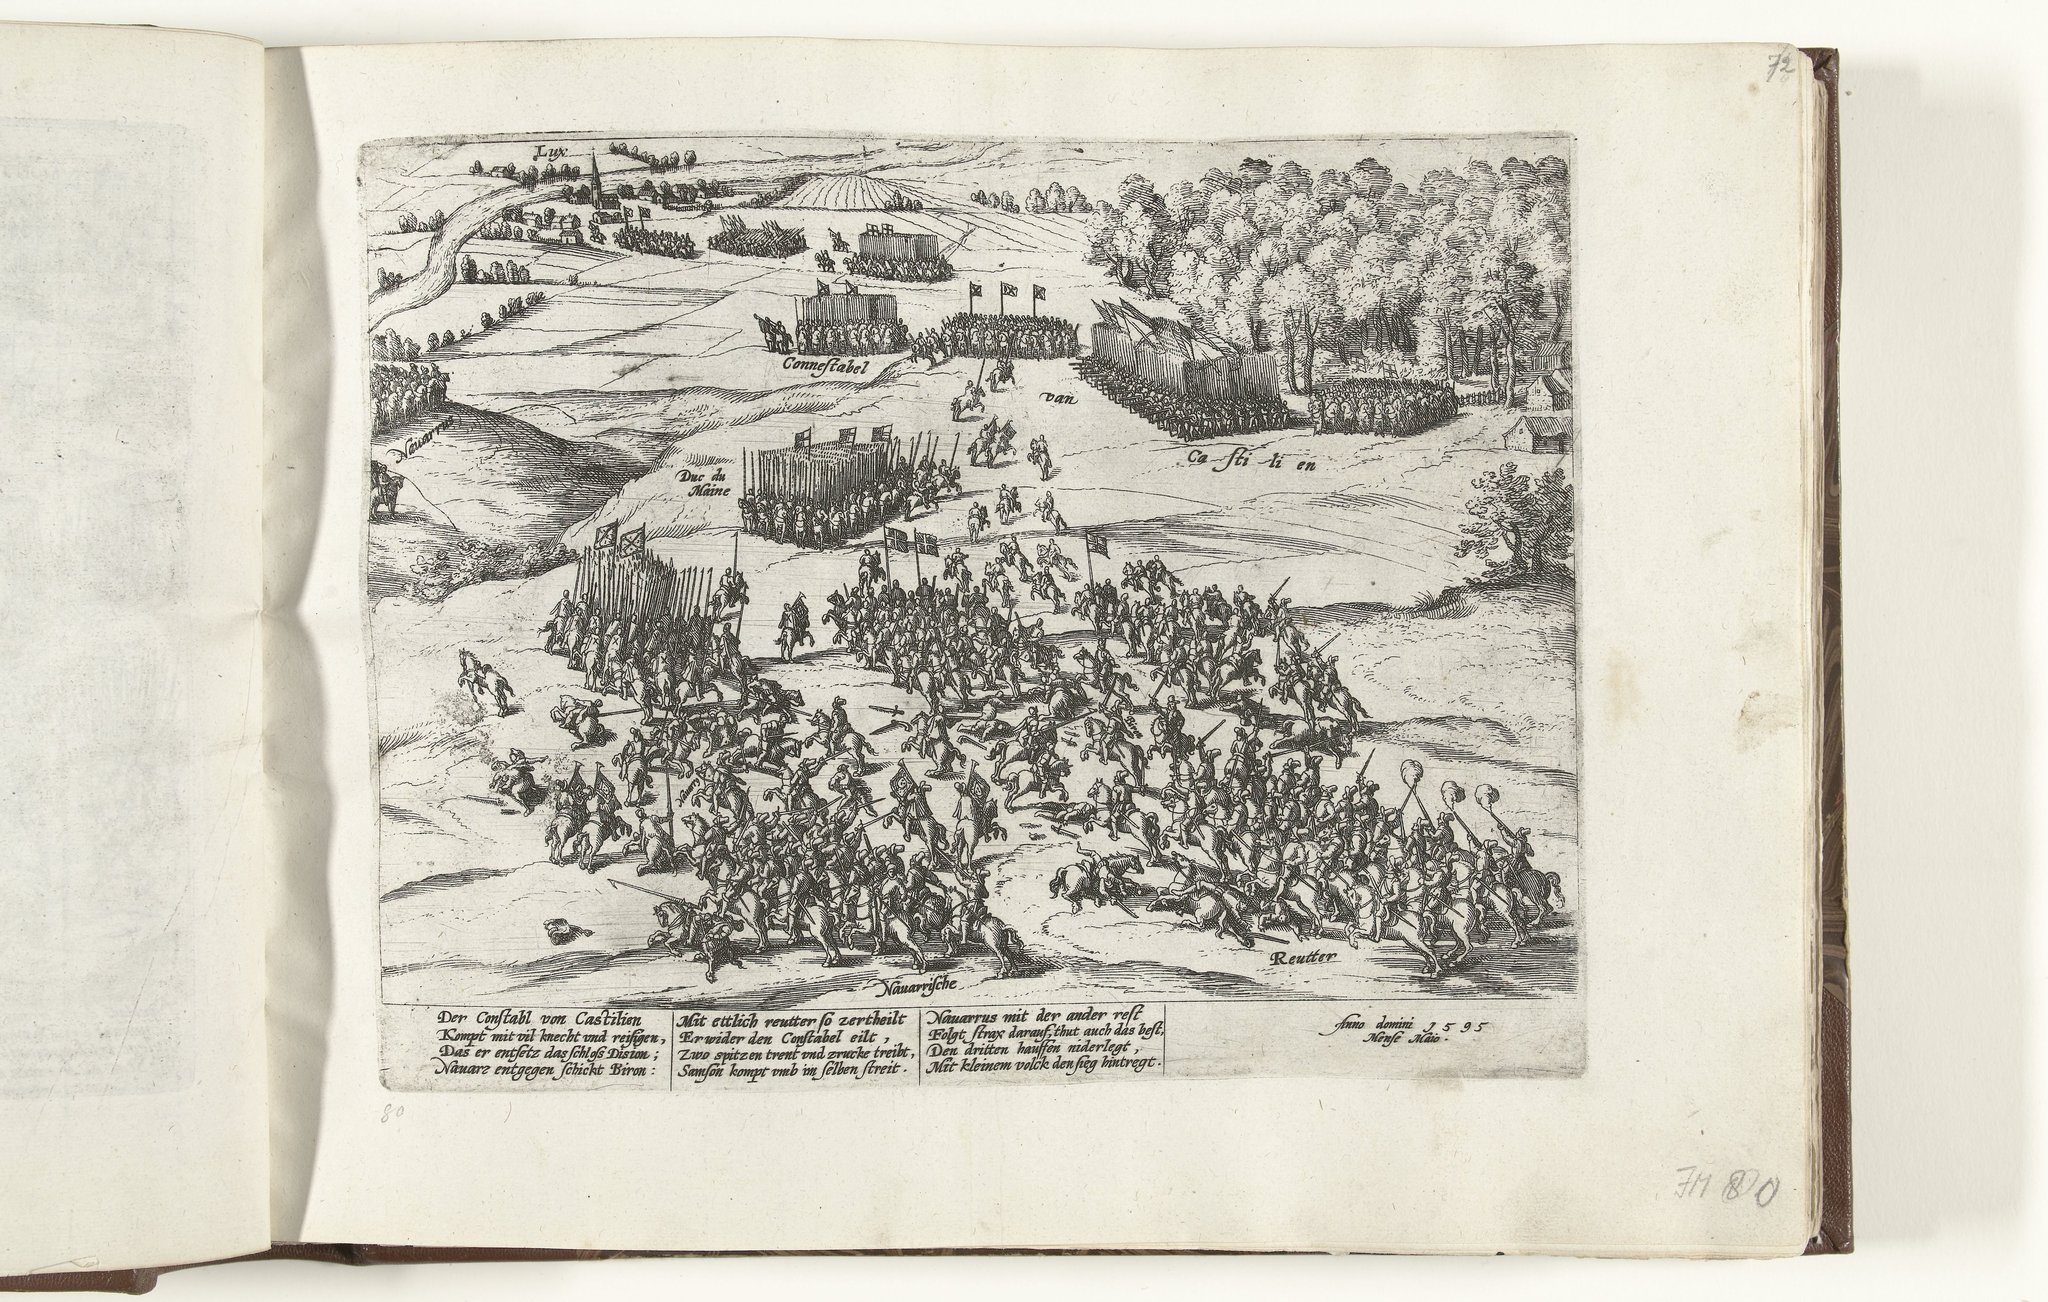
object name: album leaf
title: Serie 4: Franse, Duitse en Engelse Gebeurtenissen, 1576-1610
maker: frans hogenberg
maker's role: print maker, publisher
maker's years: 1538-1590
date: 1595-1612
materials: paper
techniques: etching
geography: cologne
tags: paris, hendrik iv (koning van frankrijk en navarra), battle, fighting in general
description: Overwinning op de Connétable van Castilië bij Dijon, mei 1595. Op de voorgrond de ruiters van de koning, in de verte de ruiters van de Connétable. Met onderschrift van 12 regels in het Duits. Ongenummerd.